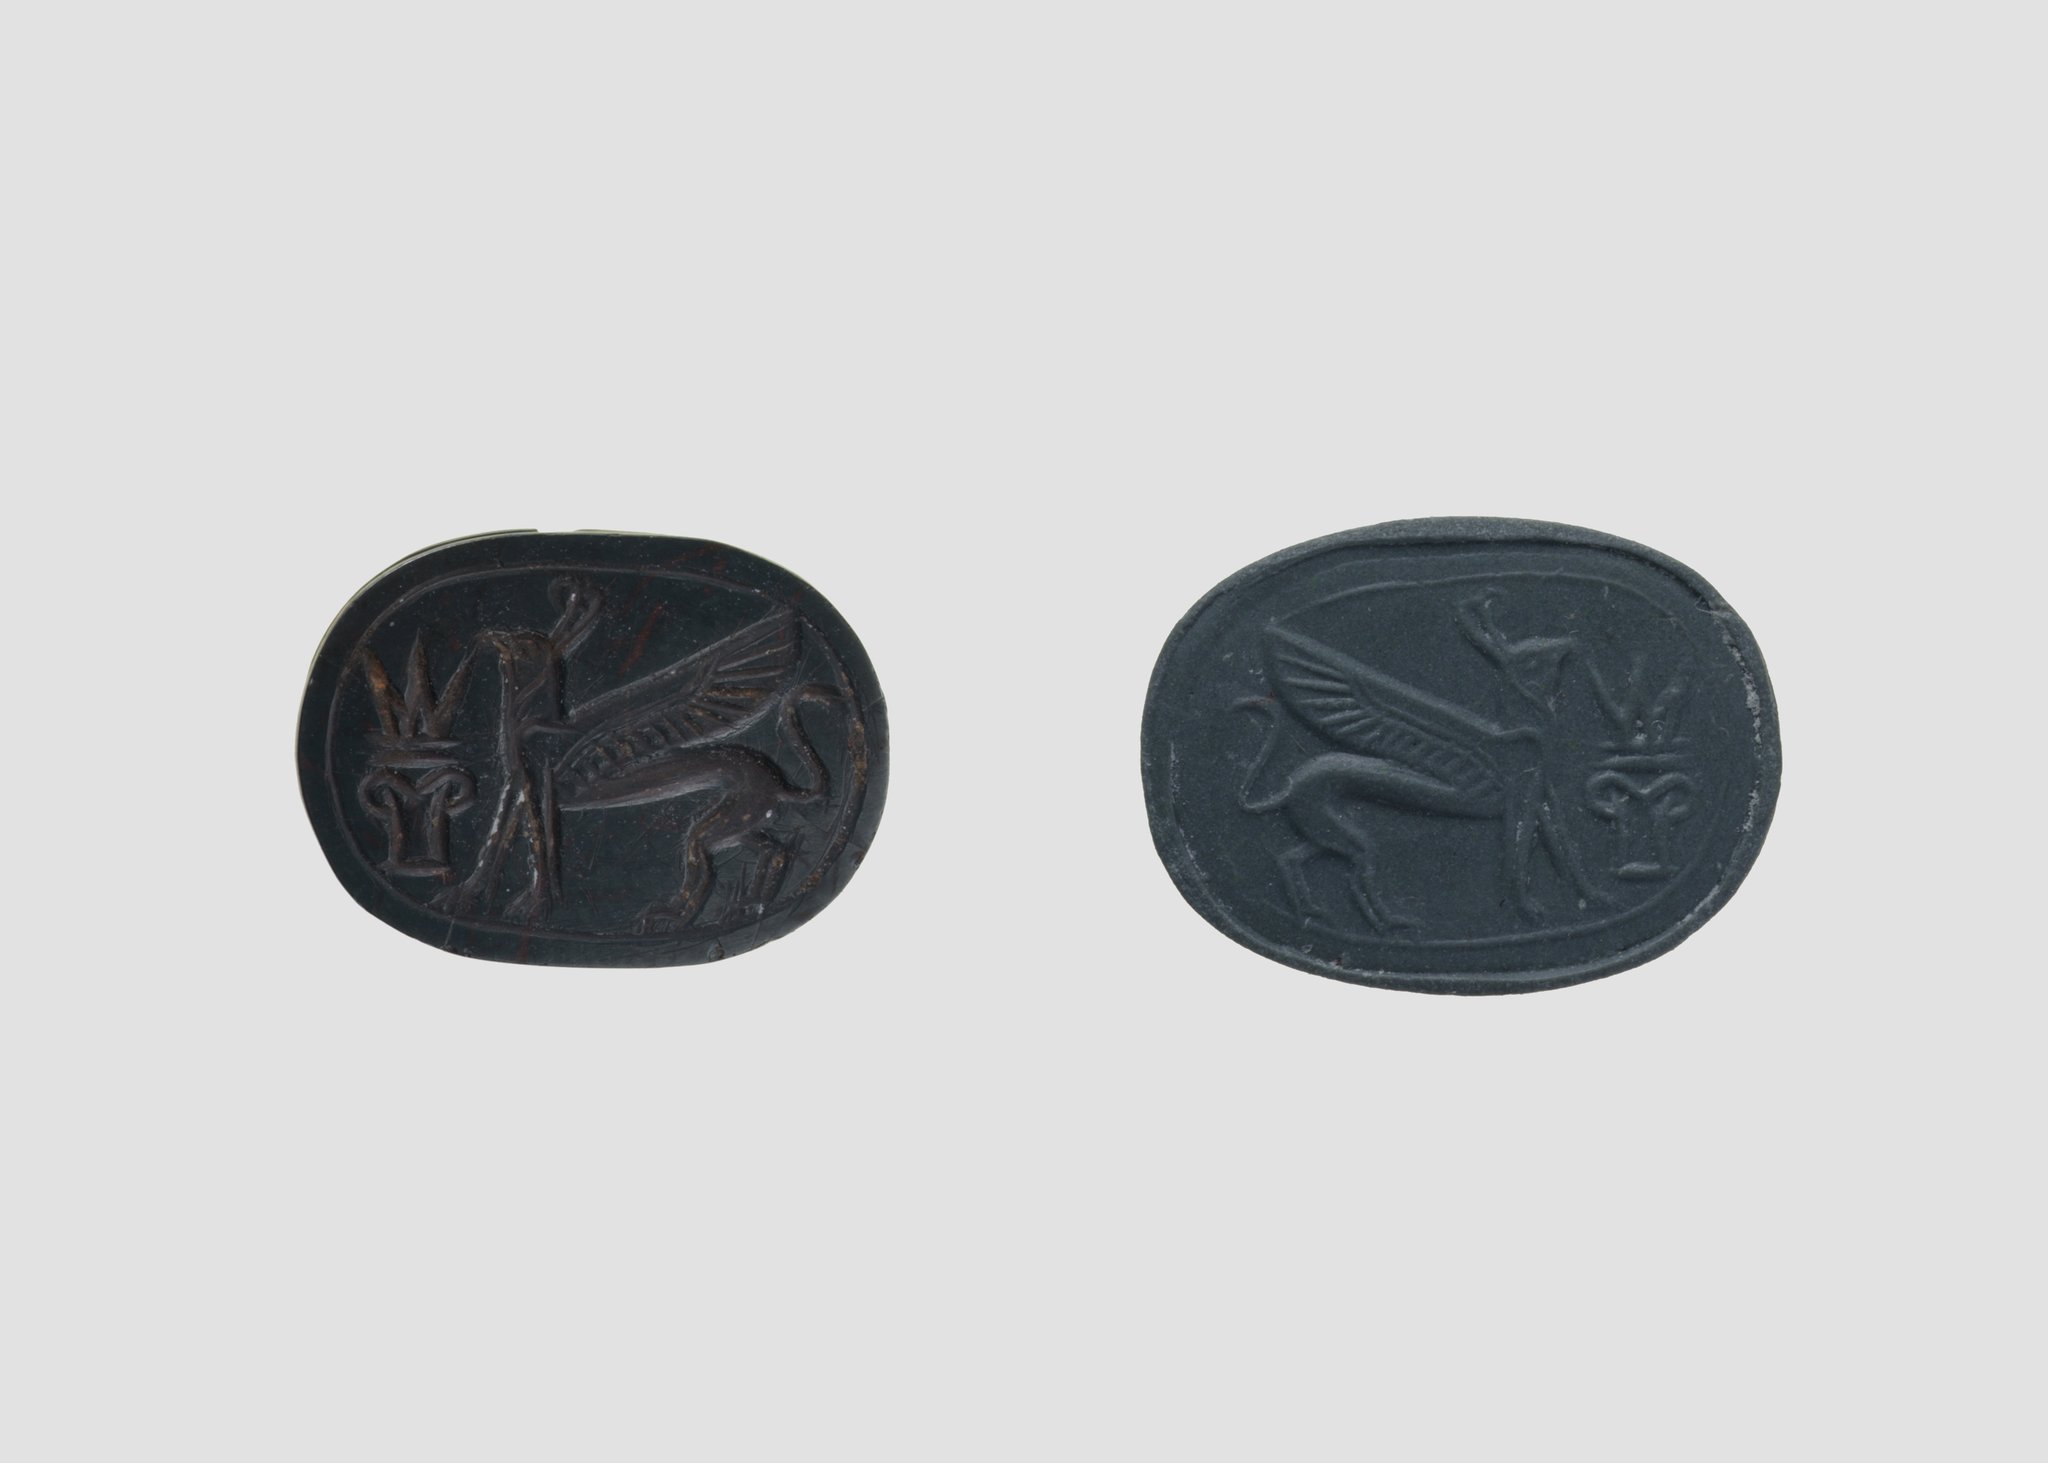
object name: stamp seal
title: Stamp seal (scarab) with monster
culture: phoenician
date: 800-601 BCE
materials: mineral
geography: levant or syria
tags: griffins